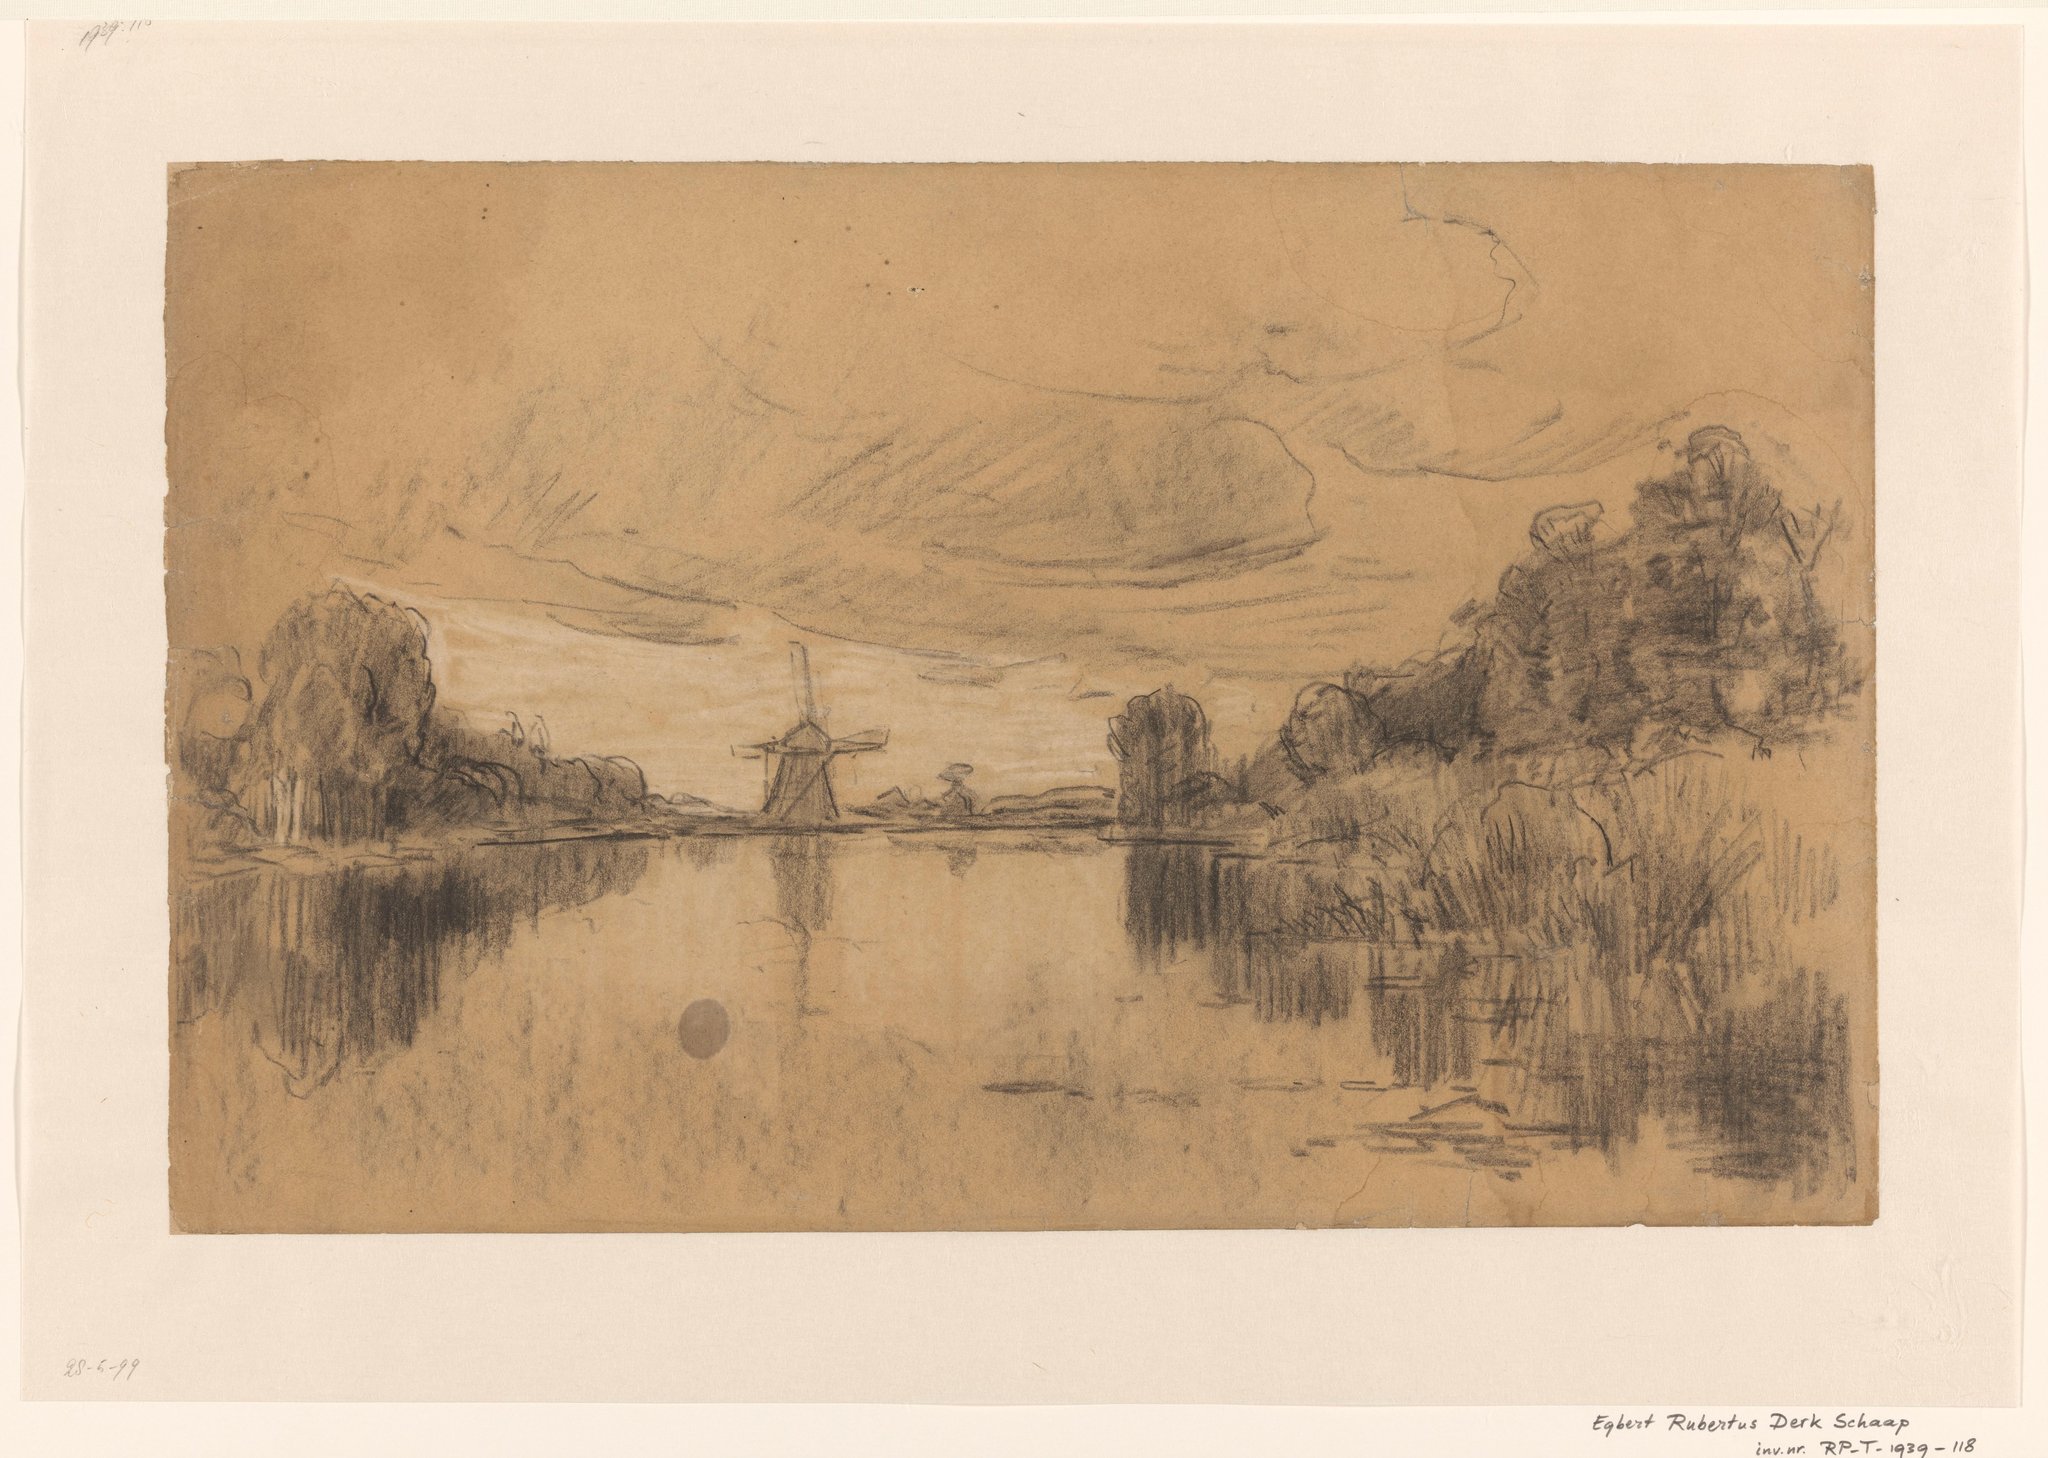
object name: drawing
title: Rivierlandschap met molen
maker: egbert rubertus derk schaap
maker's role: draughtsman, painter, print maker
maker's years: 1862-1939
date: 1872-1939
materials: chalk, paper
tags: windmill in landscape, windmill